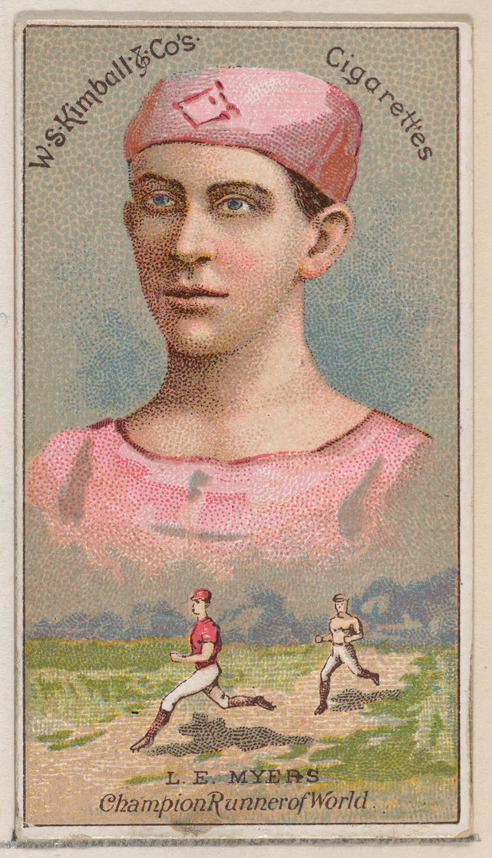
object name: print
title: L.E. Myers, Champon Runner of the World, from the Champions of Games and Sports series (N184, Type 1) issued by W.S. Kimball & Co.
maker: w.s. kimball & co.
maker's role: publisher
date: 1887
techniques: color lithograph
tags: men,running,athletes